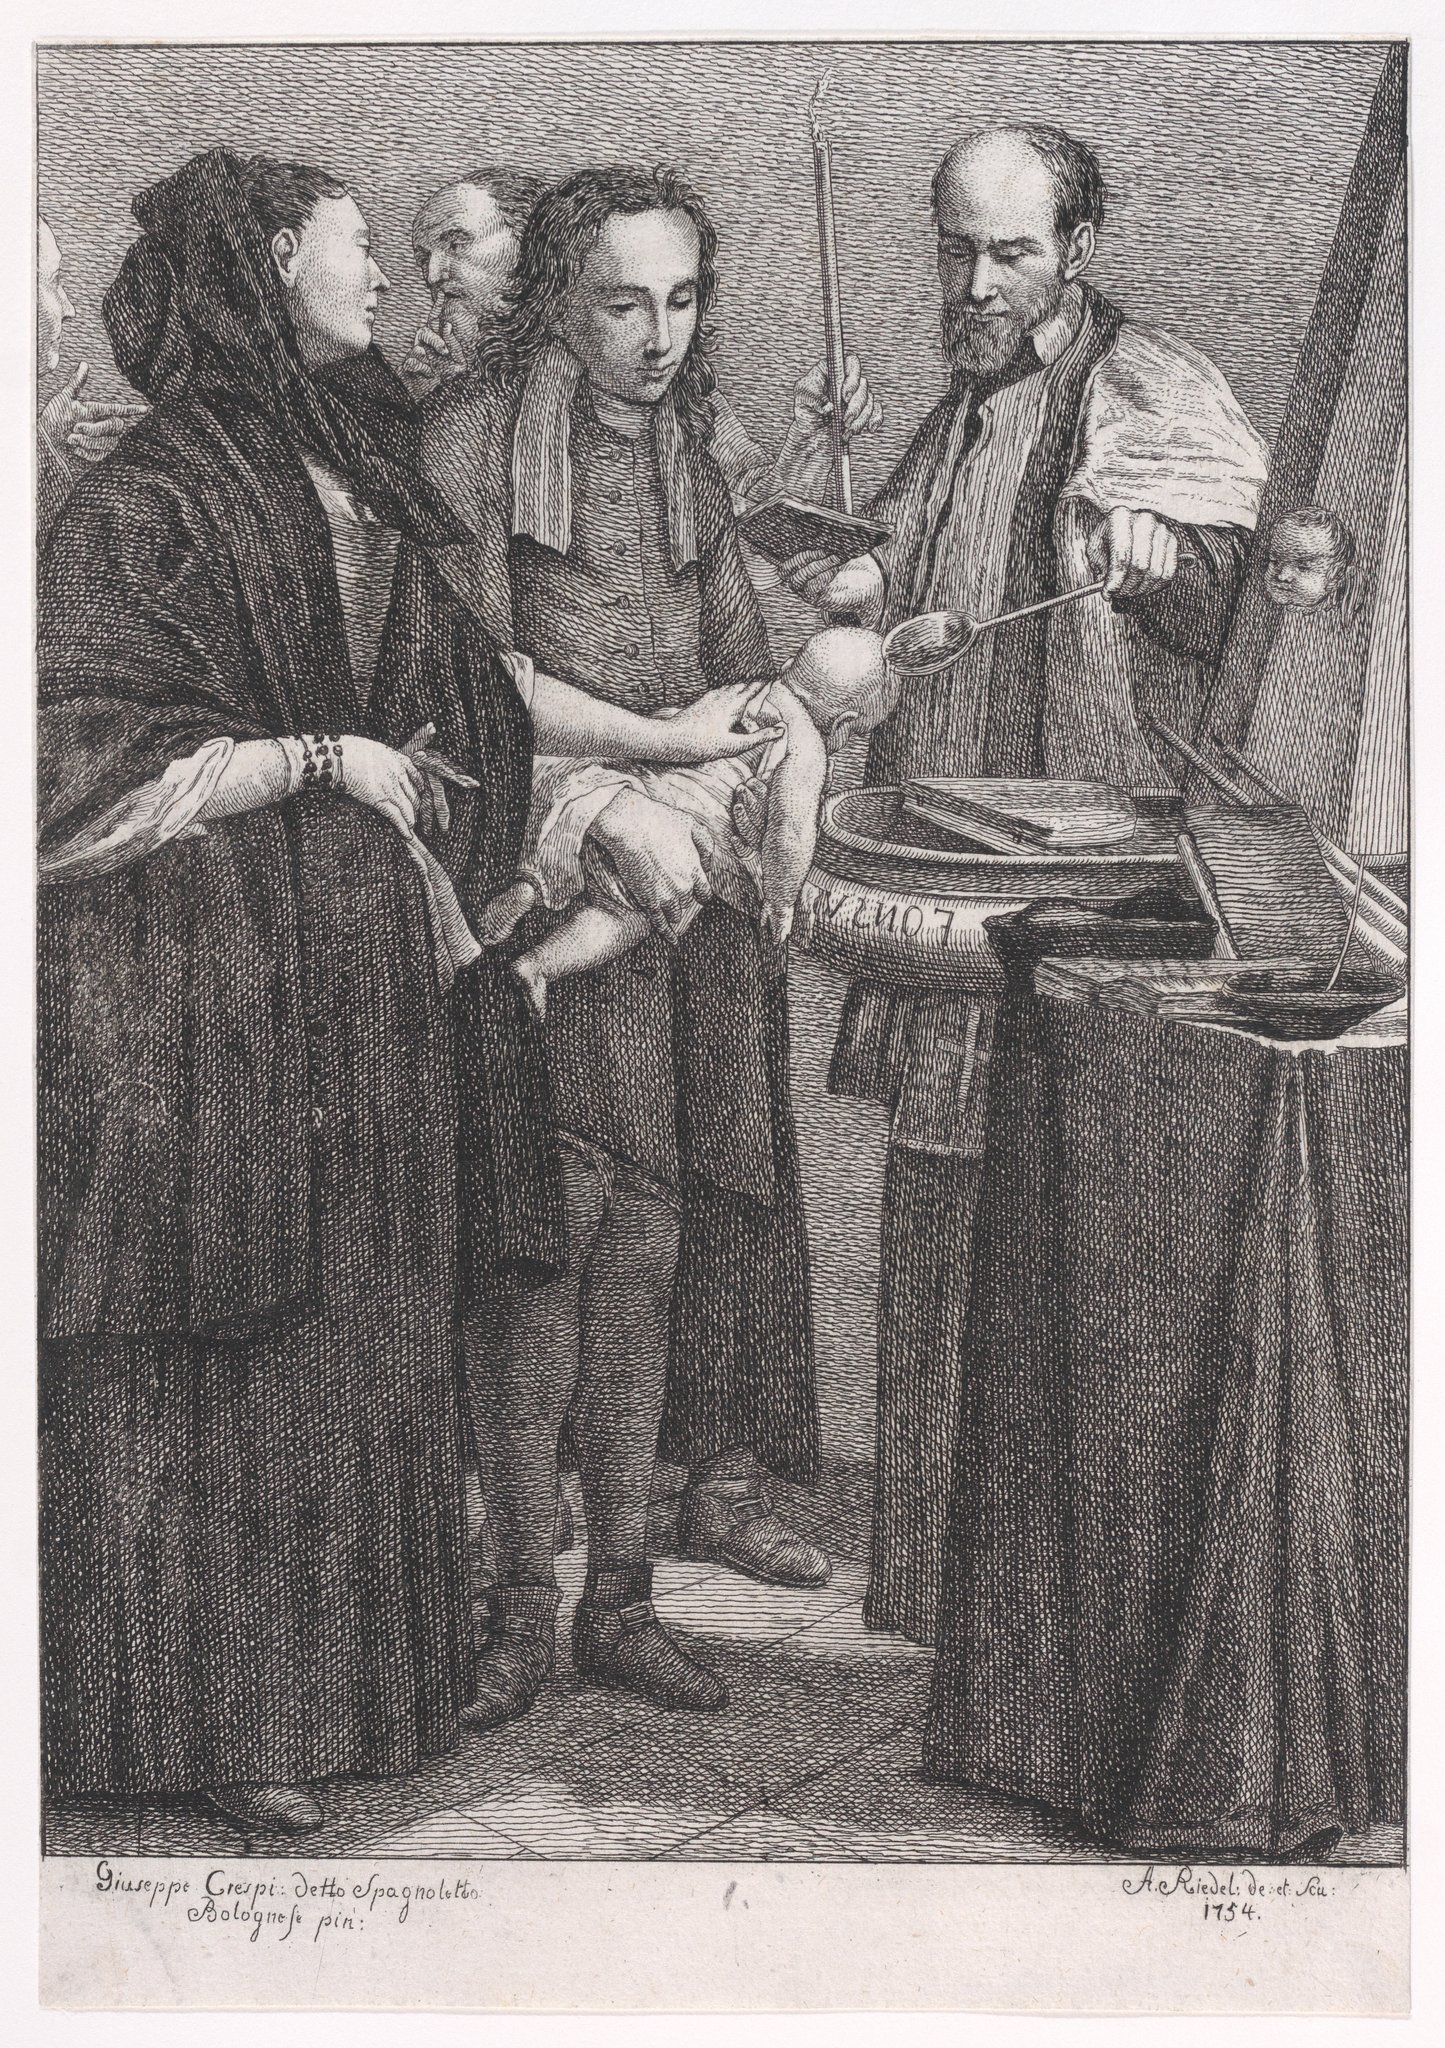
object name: print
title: Baptism, from "The Seven Sacraments"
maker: johann anton riedel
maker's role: artist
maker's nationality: swiss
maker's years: 1736-1816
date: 1754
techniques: etching